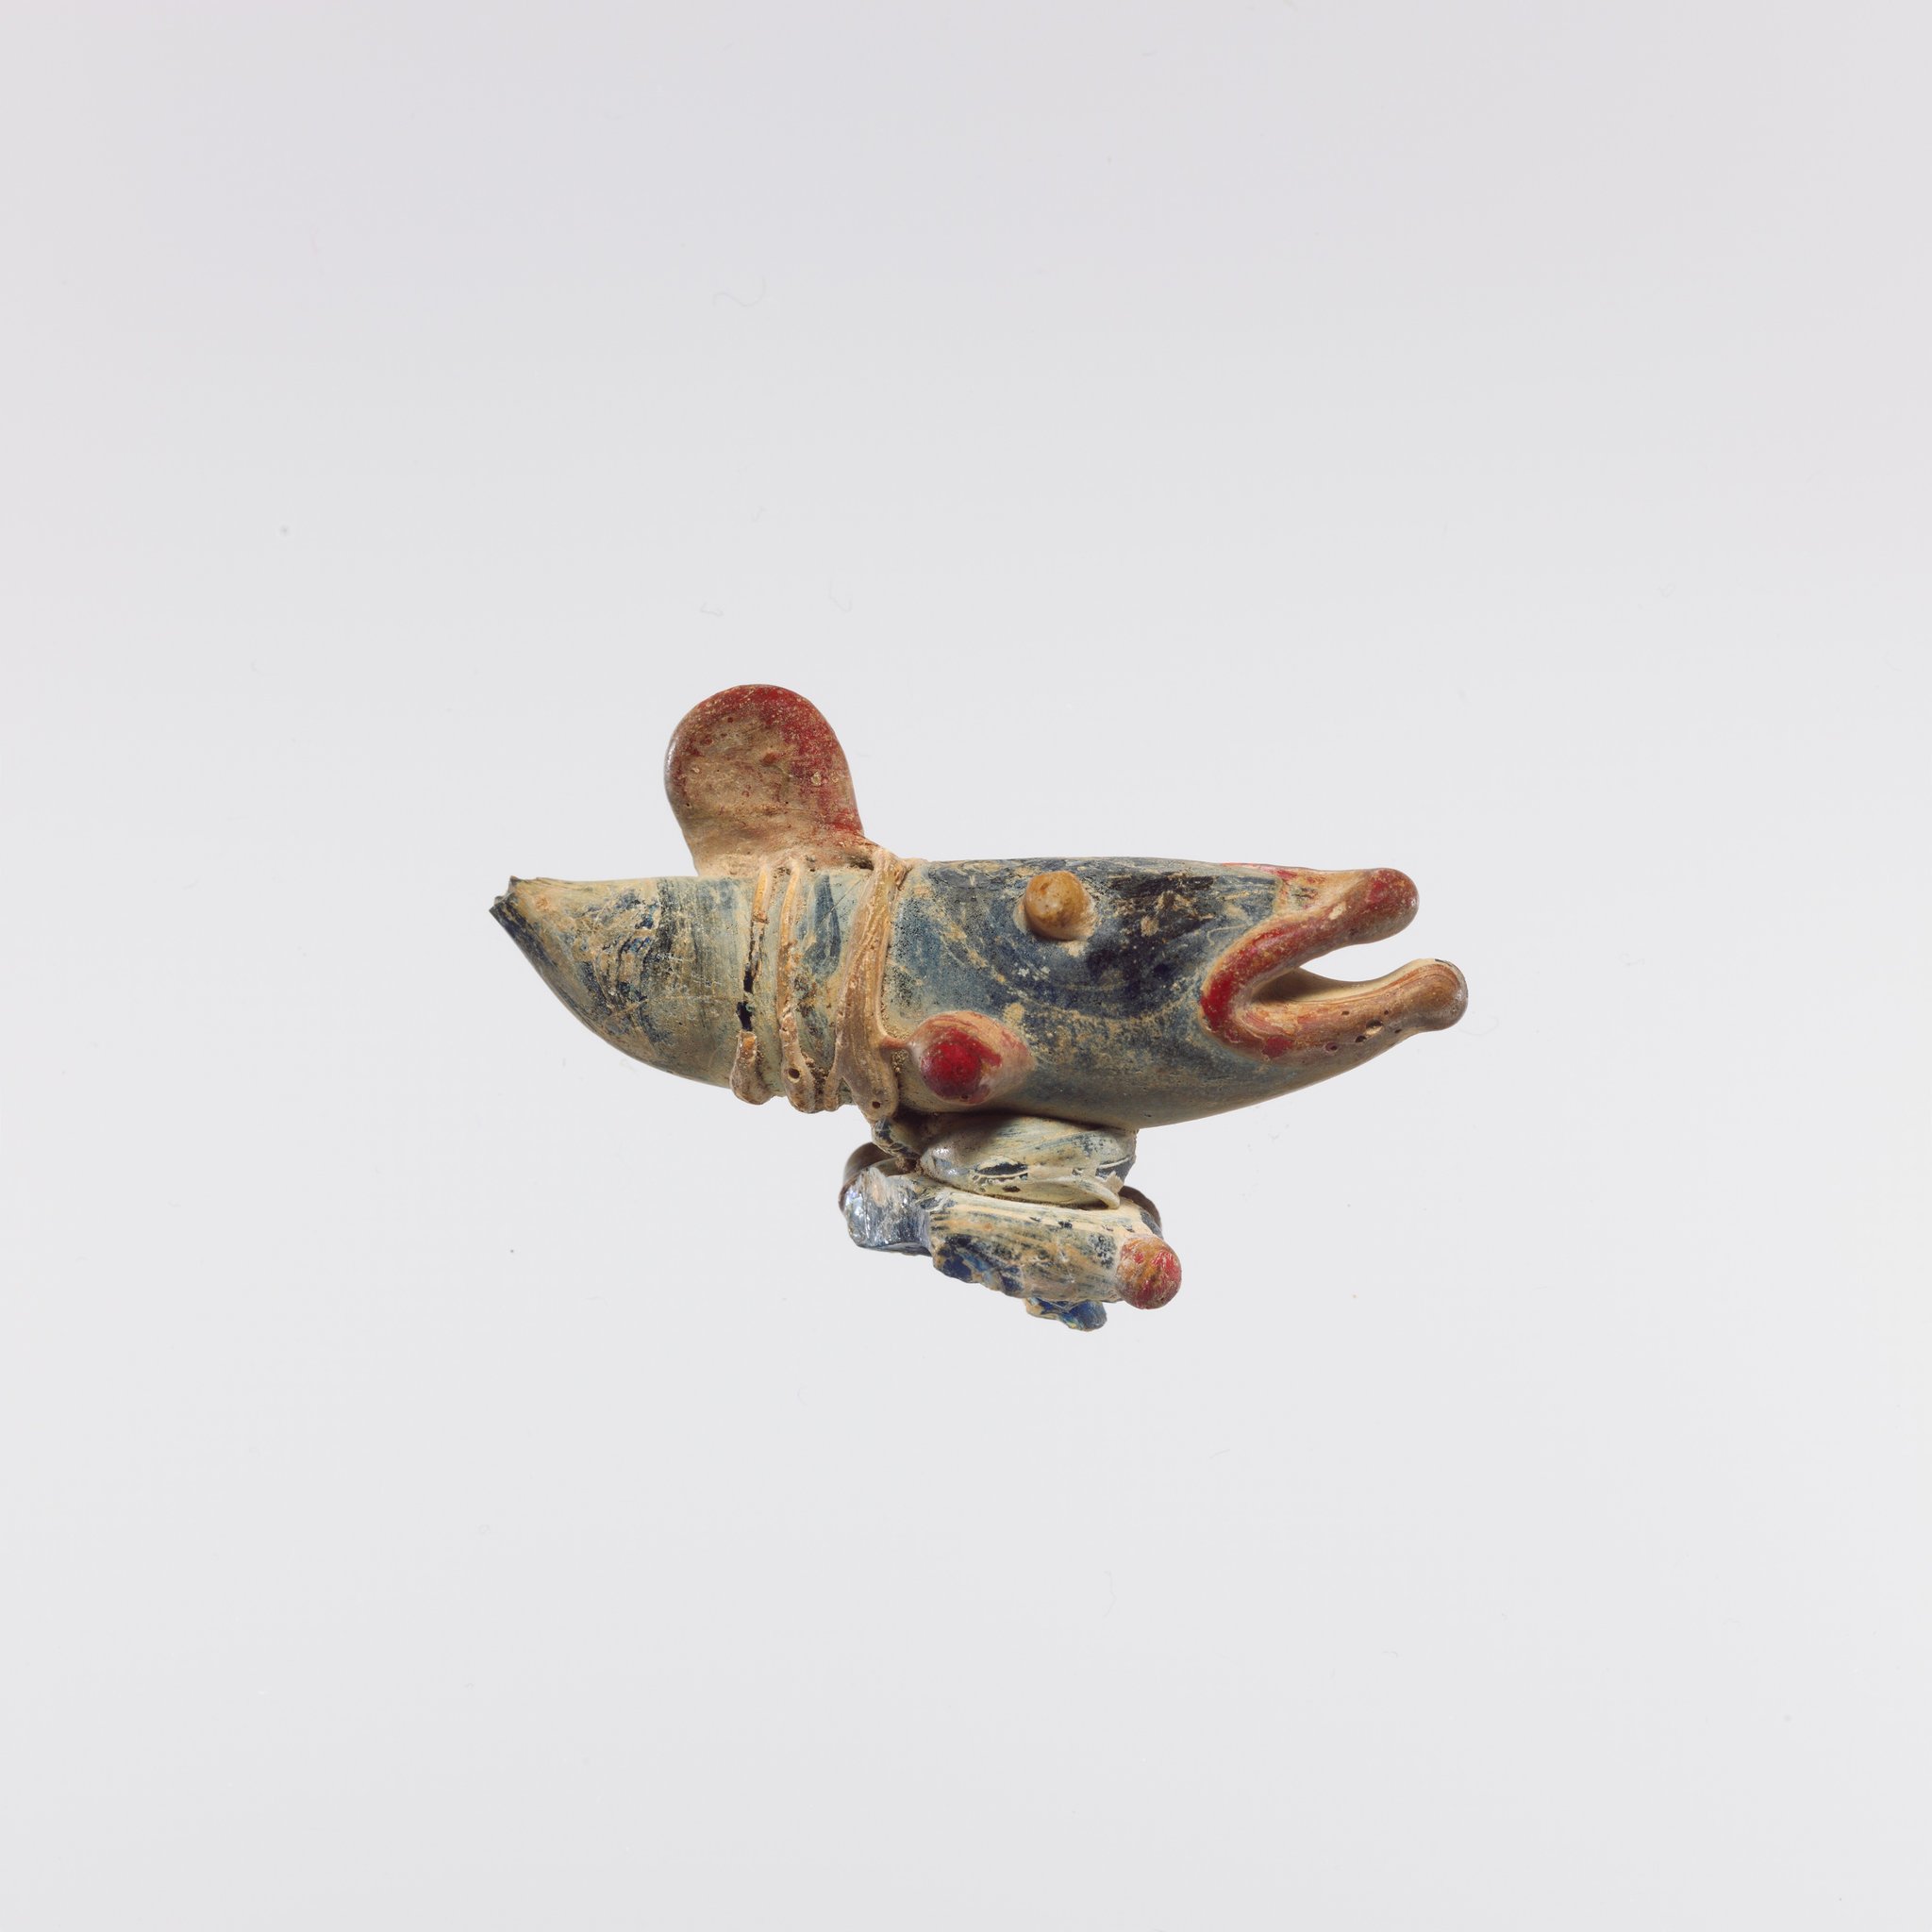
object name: ornament in the form of a fish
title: Glass ornament in the shape of a fish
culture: roman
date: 301-350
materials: glass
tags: fish